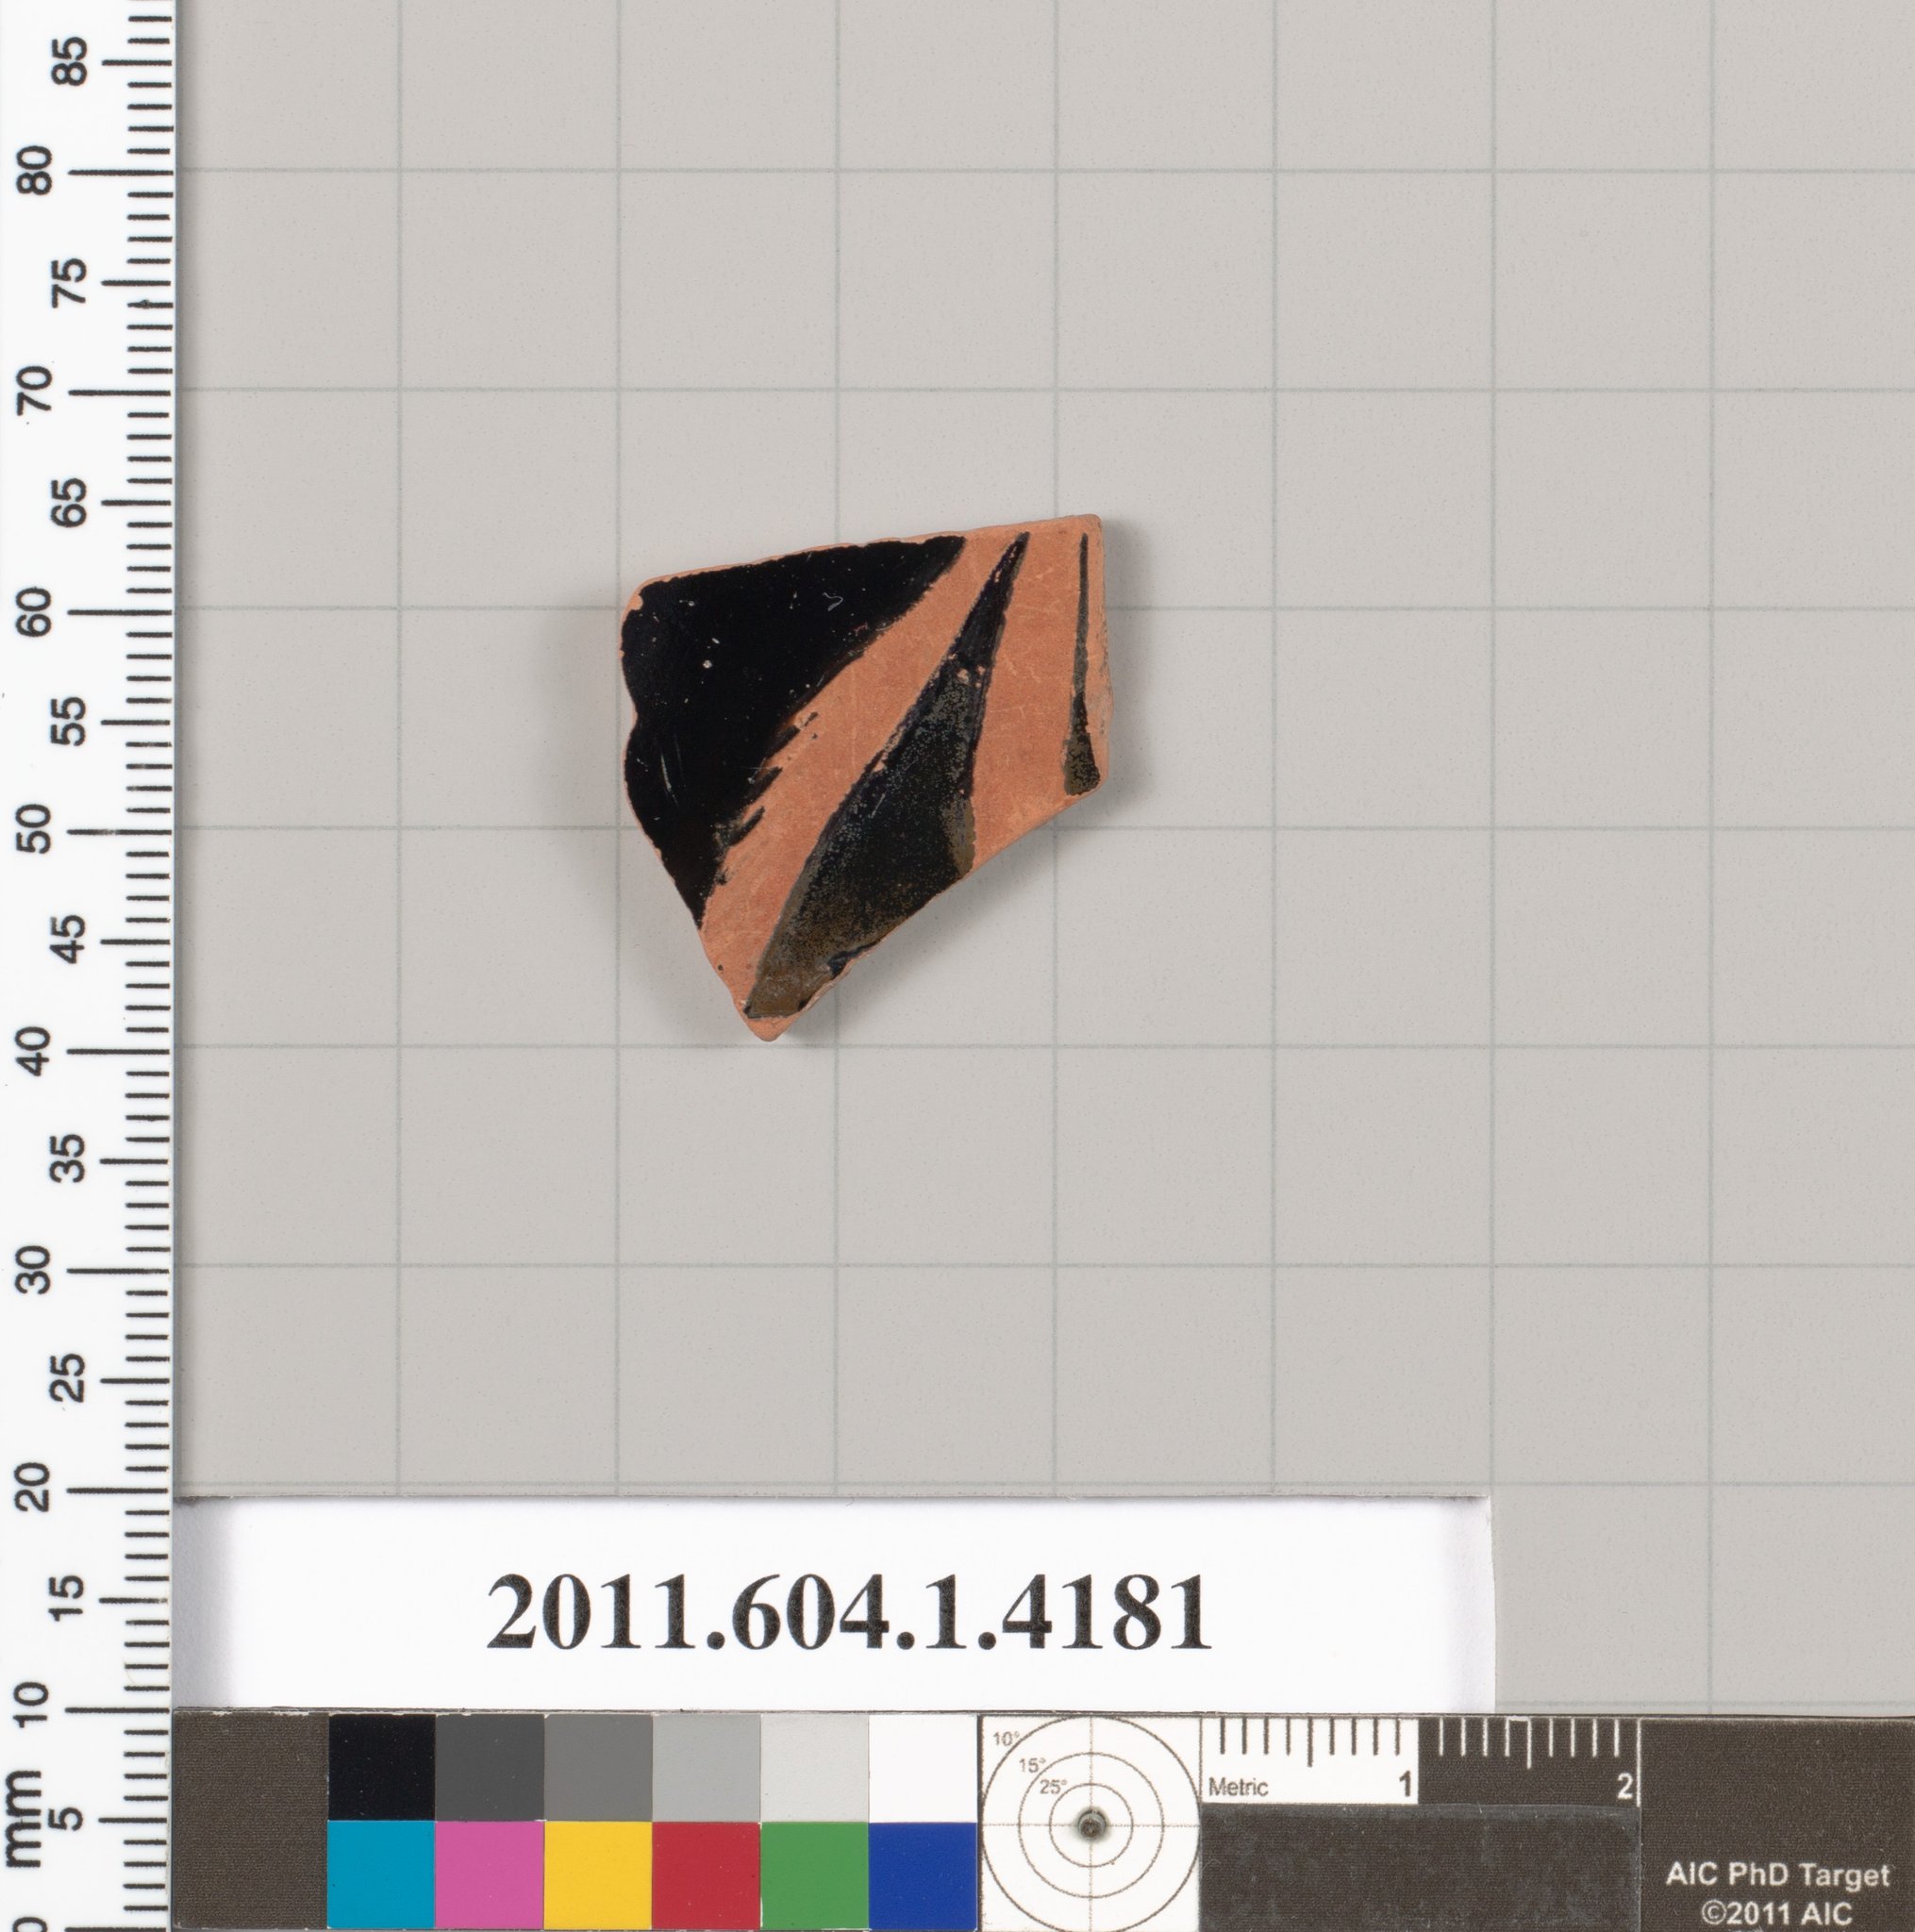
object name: kylix fragment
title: Terracotta fragment of a kylix (drinking cup)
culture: greek, attic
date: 500-480 BCE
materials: terracotta